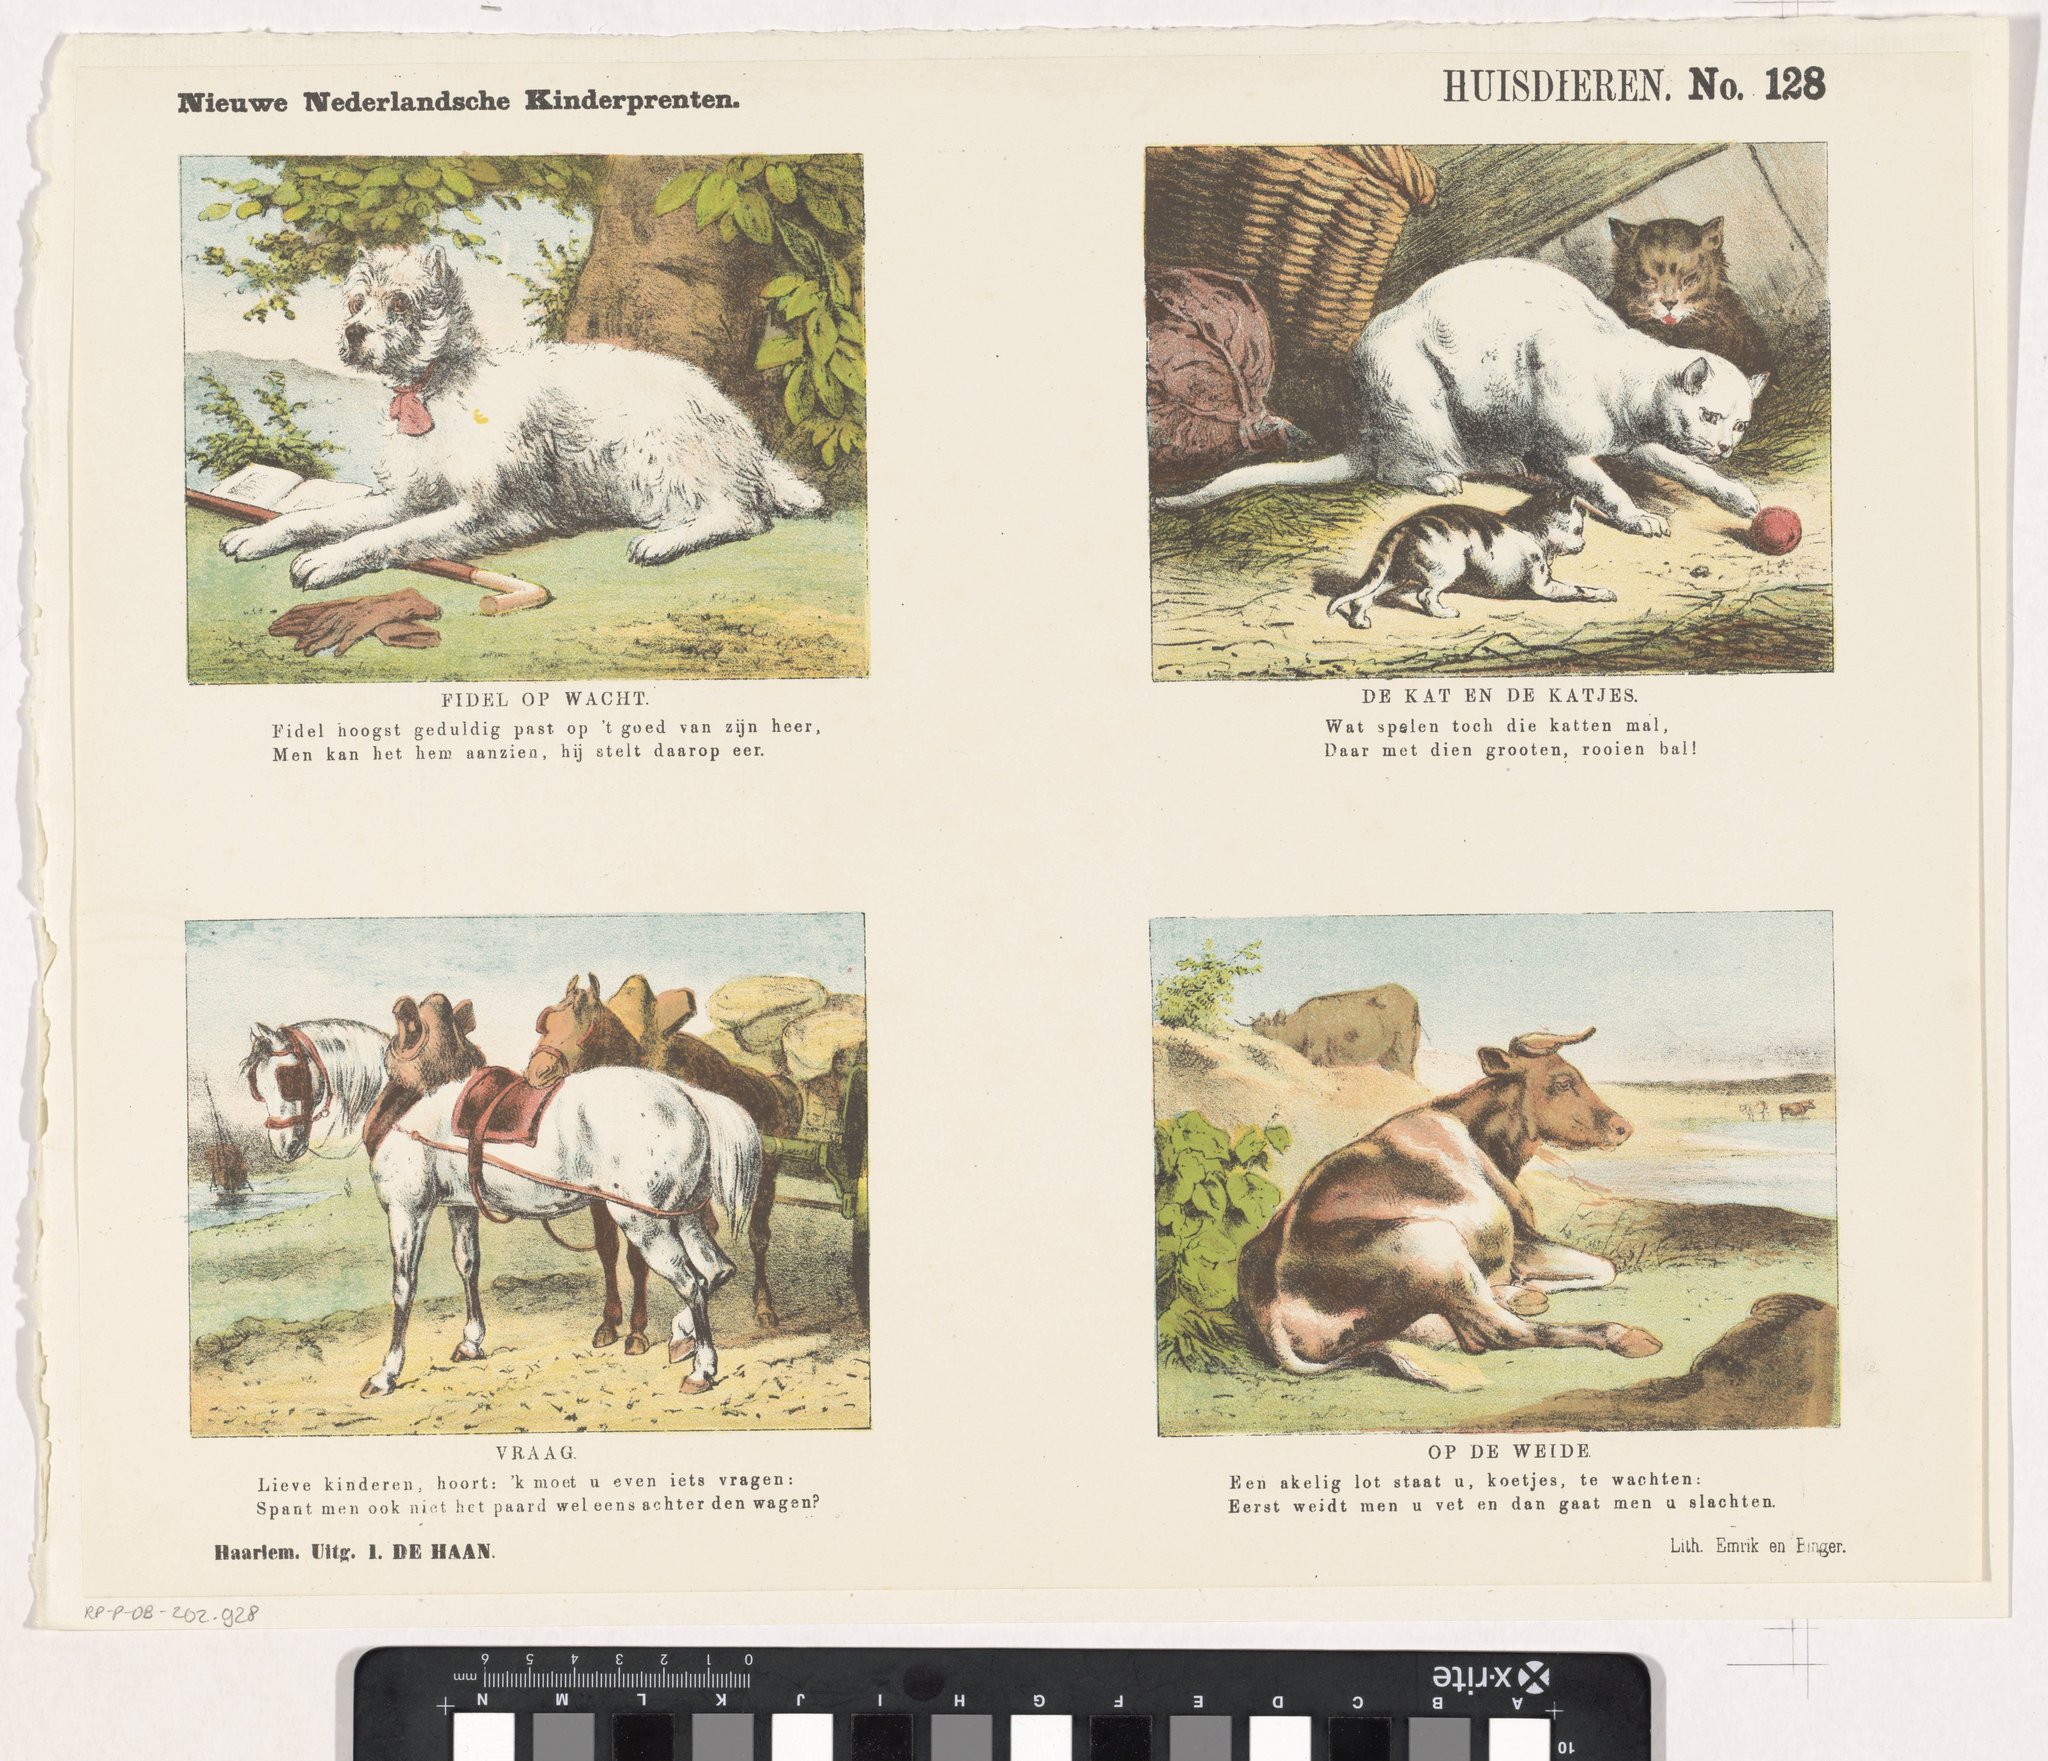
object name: print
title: Huisdieren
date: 1875-1903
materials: paper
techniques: lithograph, letterpress printing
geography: haarlem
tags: cow, cat, horse, dog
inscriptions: collector's mark: Lugt 2760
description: Blad met 4 voorstellingen van een hond, katten, paarden en koeien. Onder elke voorstelling een titel en een vers. Genummerd rechtsboven: No. 128.